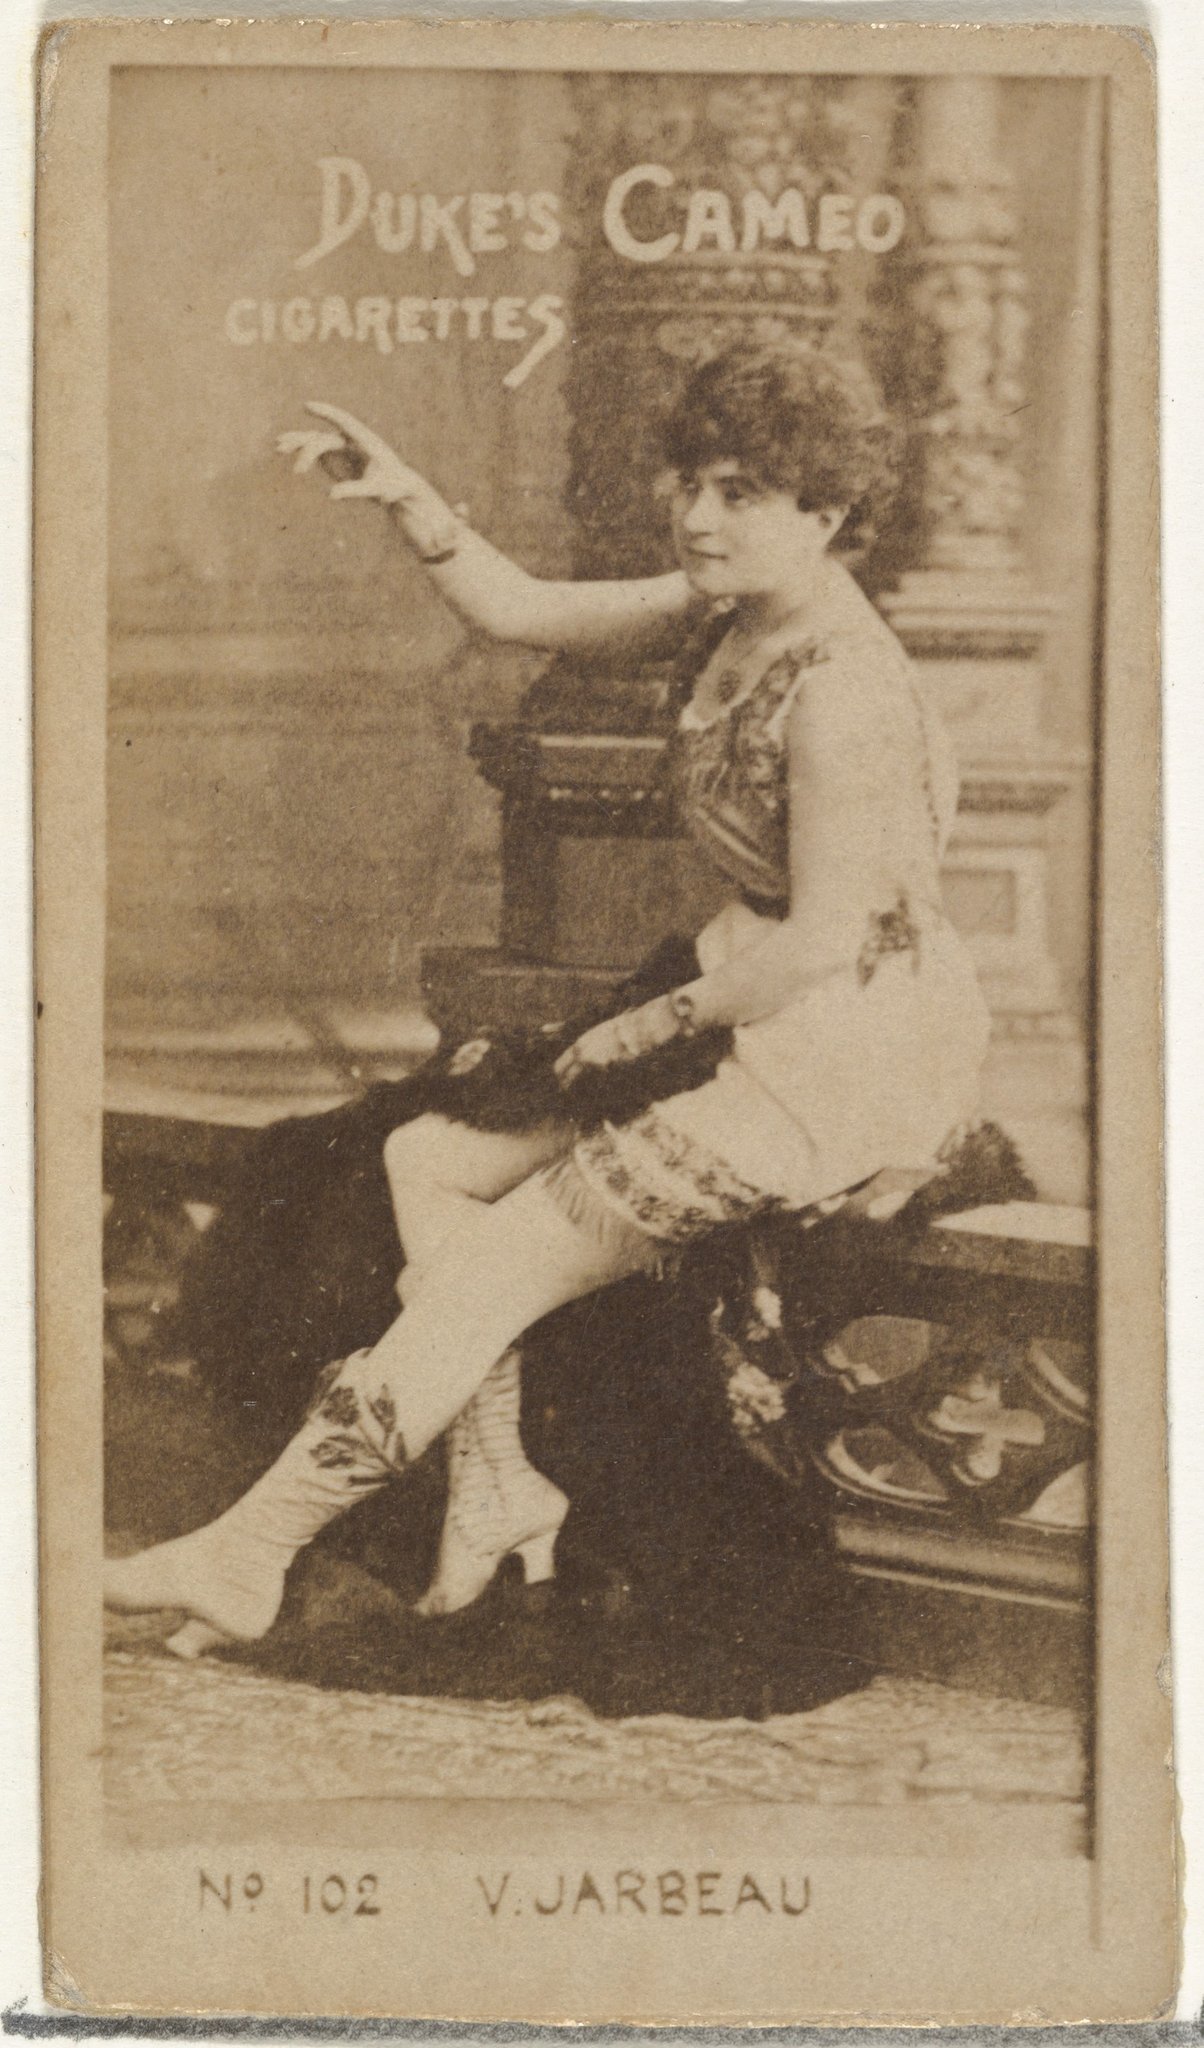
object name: photograph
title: Card Number 102, Vernona Jarbeau, from the Actors and Actresses series (N145-4) issued by Duke Sons & Co. to promote Cameo Cigarettes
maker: w. duke, sons & co.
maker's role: publisher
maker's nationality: american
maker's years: 1870-1920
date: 1880-1889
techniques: albumen silver print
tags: portraits,women,actresses